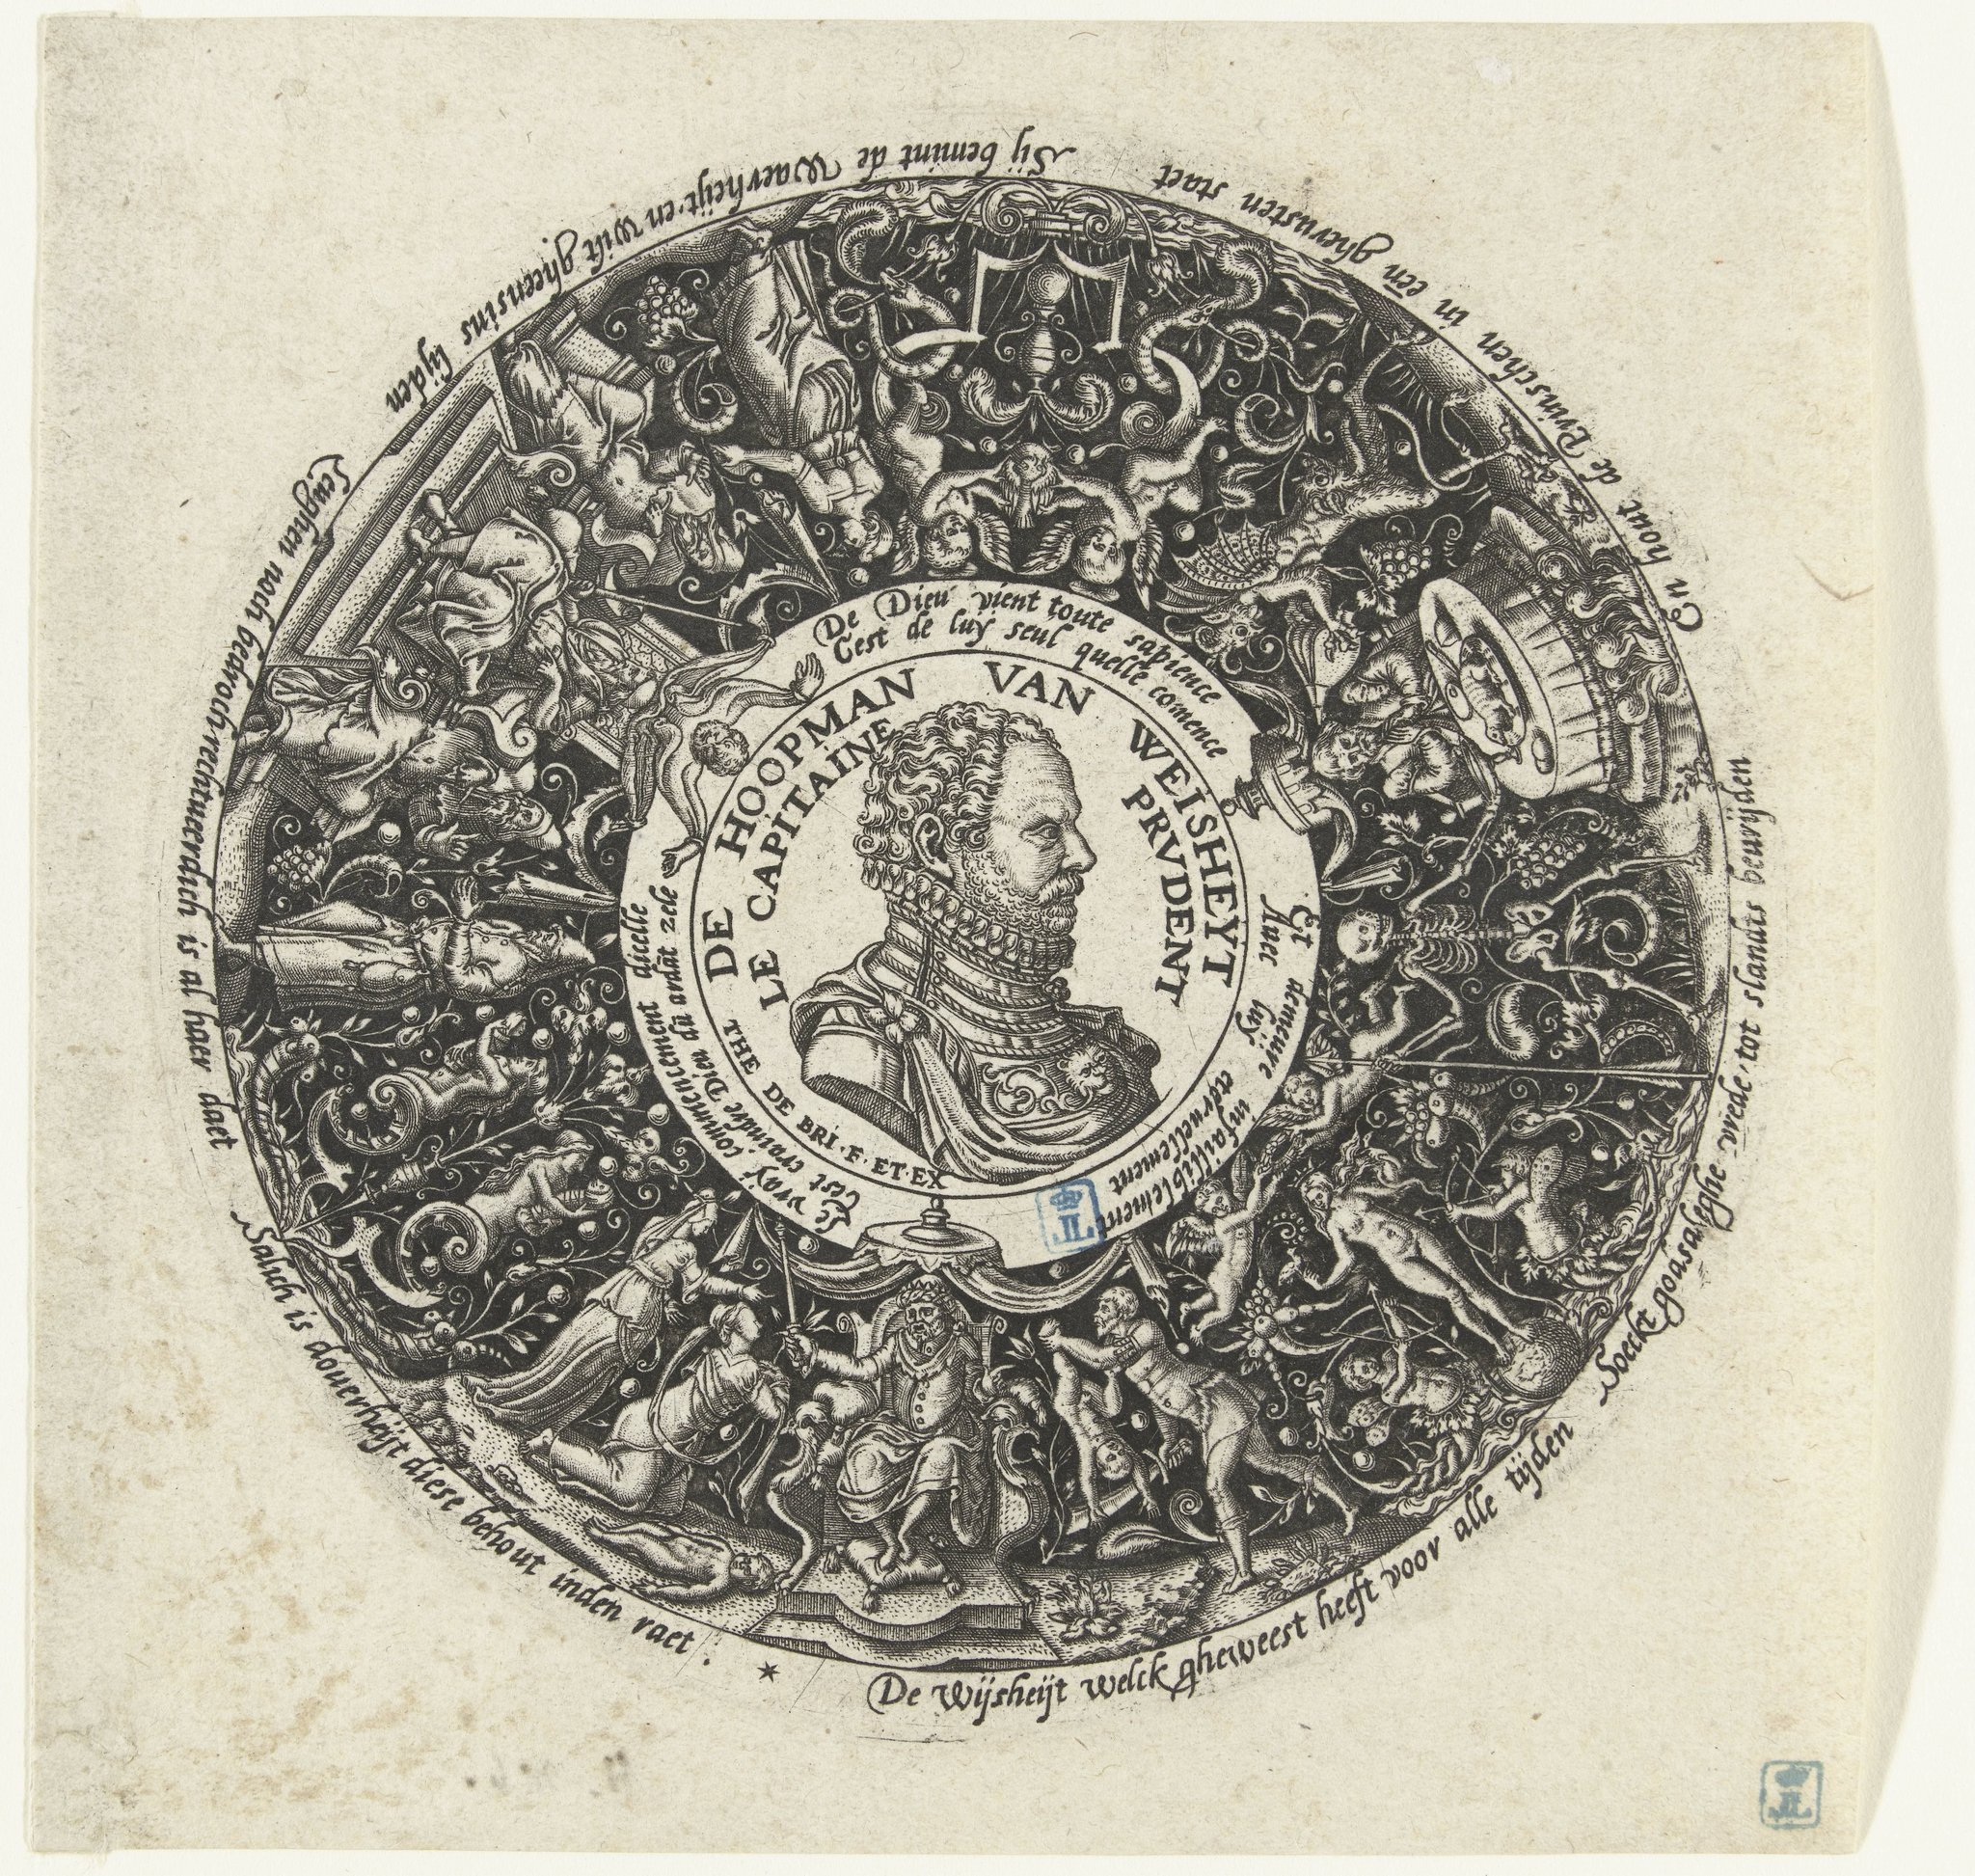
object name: print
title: De Hoopman van Weisheyt / le capitaine prvdent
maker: theodor de bry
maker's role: draughtsman, print maker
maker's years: 1528-1598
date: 1577-1578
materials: paper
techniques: engraving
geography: netherlands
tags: delft, william i (prince of orange), the judgement of solomon (1 kings 3:16-28), historical persons, judgement of cambyses: he appoints sisamnes' son to succeed his father, whose skin is nailed onto the judgement-seat (possibly flaying of sisamnes visible)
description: Medaillon met de buste van de "Hoopman van Weisheyt" (portret van Willem van Oranje). In de rand met grotesken worden de oordelen van Salomo en Cambyses afgebeeld en een voorstelling van de godsvruchtige vorst, onbeïnvloed door dood en verderf. Blad uit serie van 4 bladen met een medaillon in een brede rand van grotesken met figuren, dieren en bladranken op een donker fond. De rand rondom het medaillon en de buitenrand bevatten Nederlandse en Franse versregels.